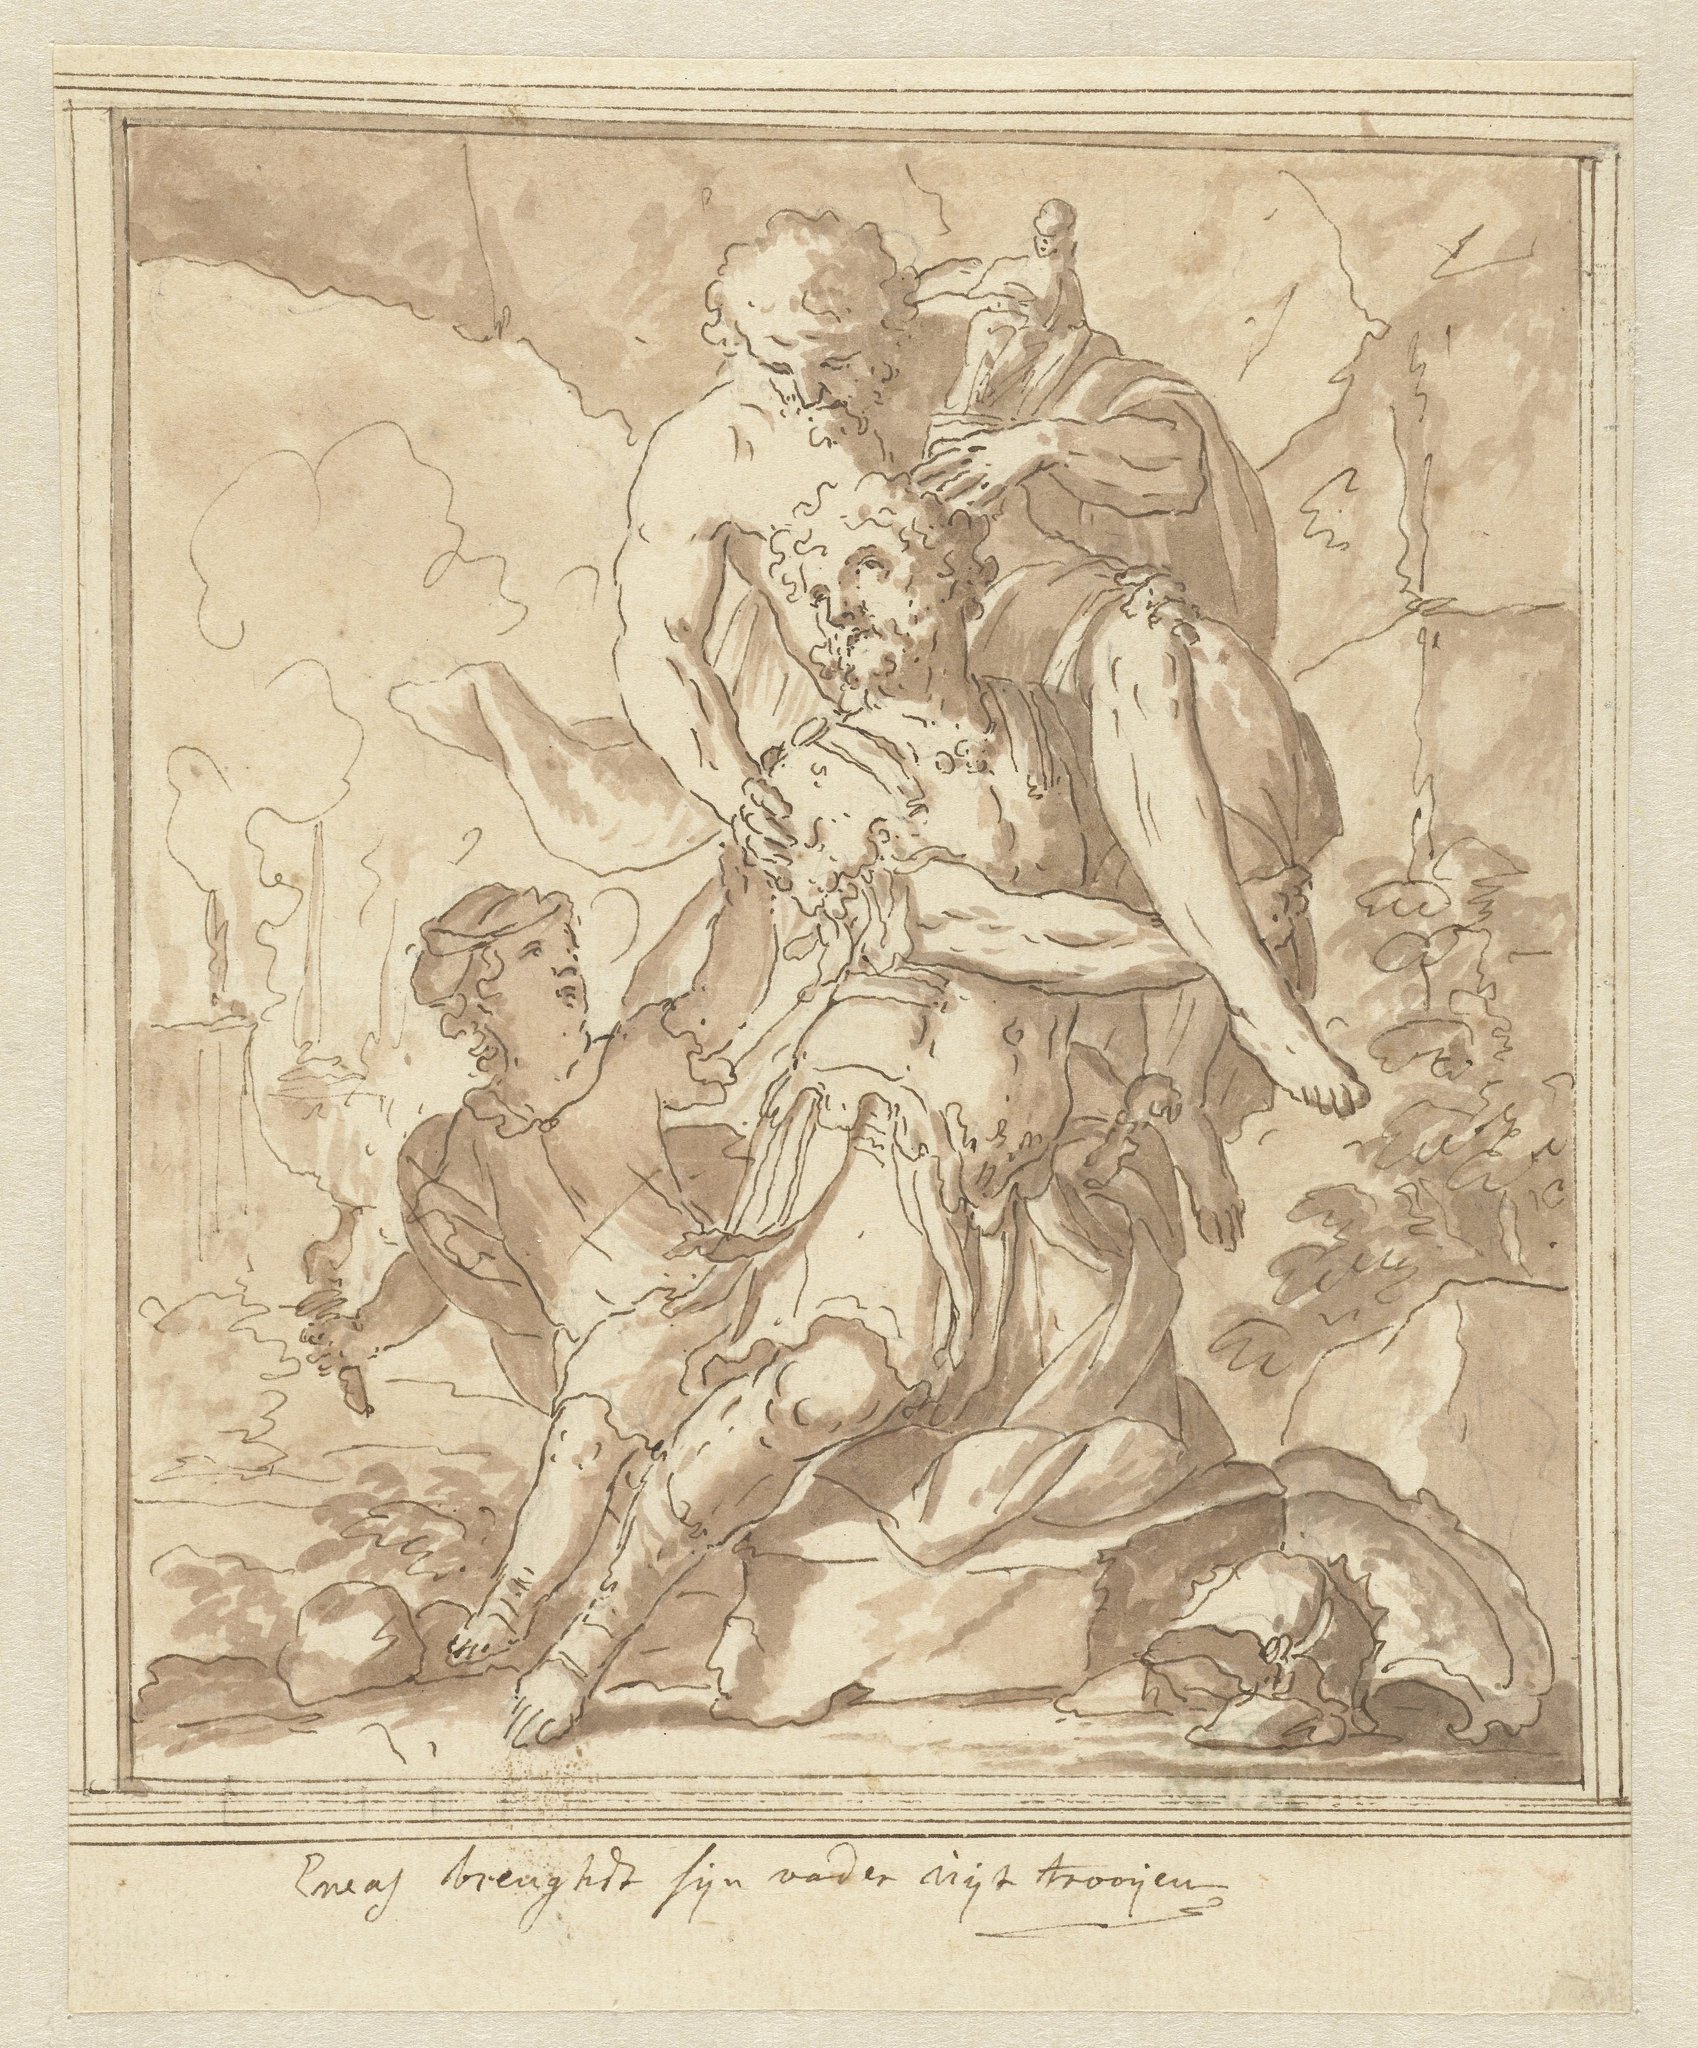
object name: design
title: Ontwerpen voor schilderijen met episodes uit De Aeneas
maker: mattheus terwesten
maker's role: draughtsman, painter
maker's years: 1670-1757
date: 1600-1604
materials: graphite, ink, paper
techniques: brush, pen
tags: 'pius aeneas': aeneas, leading ascanius, escapes from burning troy, carrying his father anchises with the penates; his wife creusa, who sets out with them, is lost on the way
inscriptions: : ‘Eneas brenght sijn vader uijt trooyen’